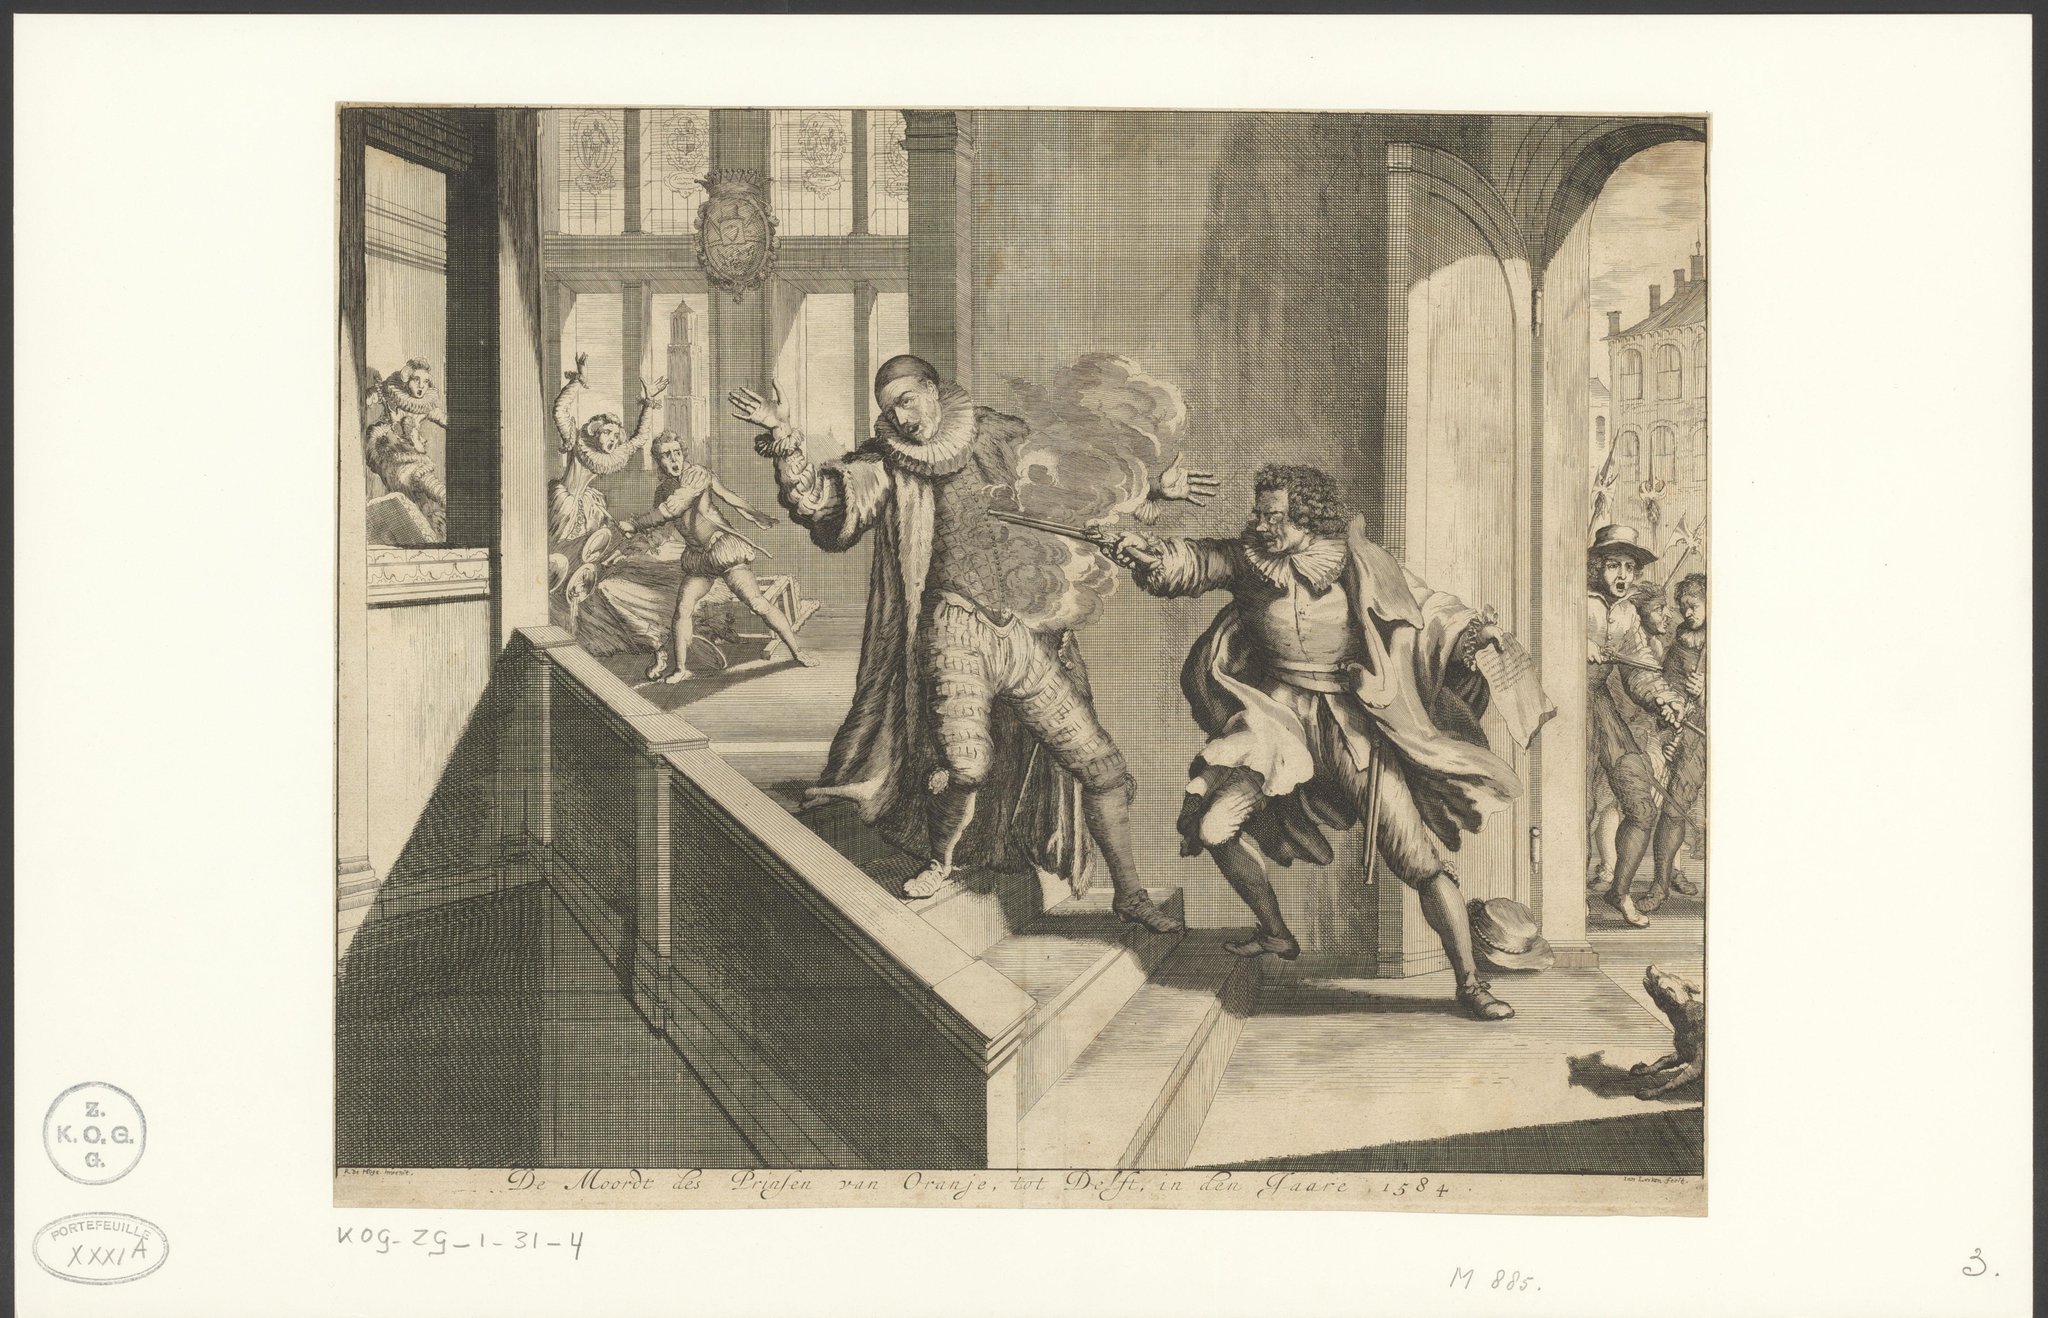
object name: print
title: De Moordt des Prinsen van Oranje, tot Delft, in den Jaare 1584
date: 1678-1680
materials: paper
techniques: engraving, etching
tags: william i (prince of orange), attempt, political murder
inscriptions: collector's mark: Lugt 1641, stamp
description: De prins van Oranje te Delft vermoord door Balthasar Gerards, 10 juli 1584. Willem van Oranje wordt op een trap bij de openstaande deur neergeschoten door Balthasar Gerards. Onderwerpsrubrieken binnen de Atlas Zeden en Gewoonten: Portretten, Portretten van Vorsten uit het huis van Oranje, Regeerende Vorsten, Stadhouders van Holland, Zeeland en West-Friesland.